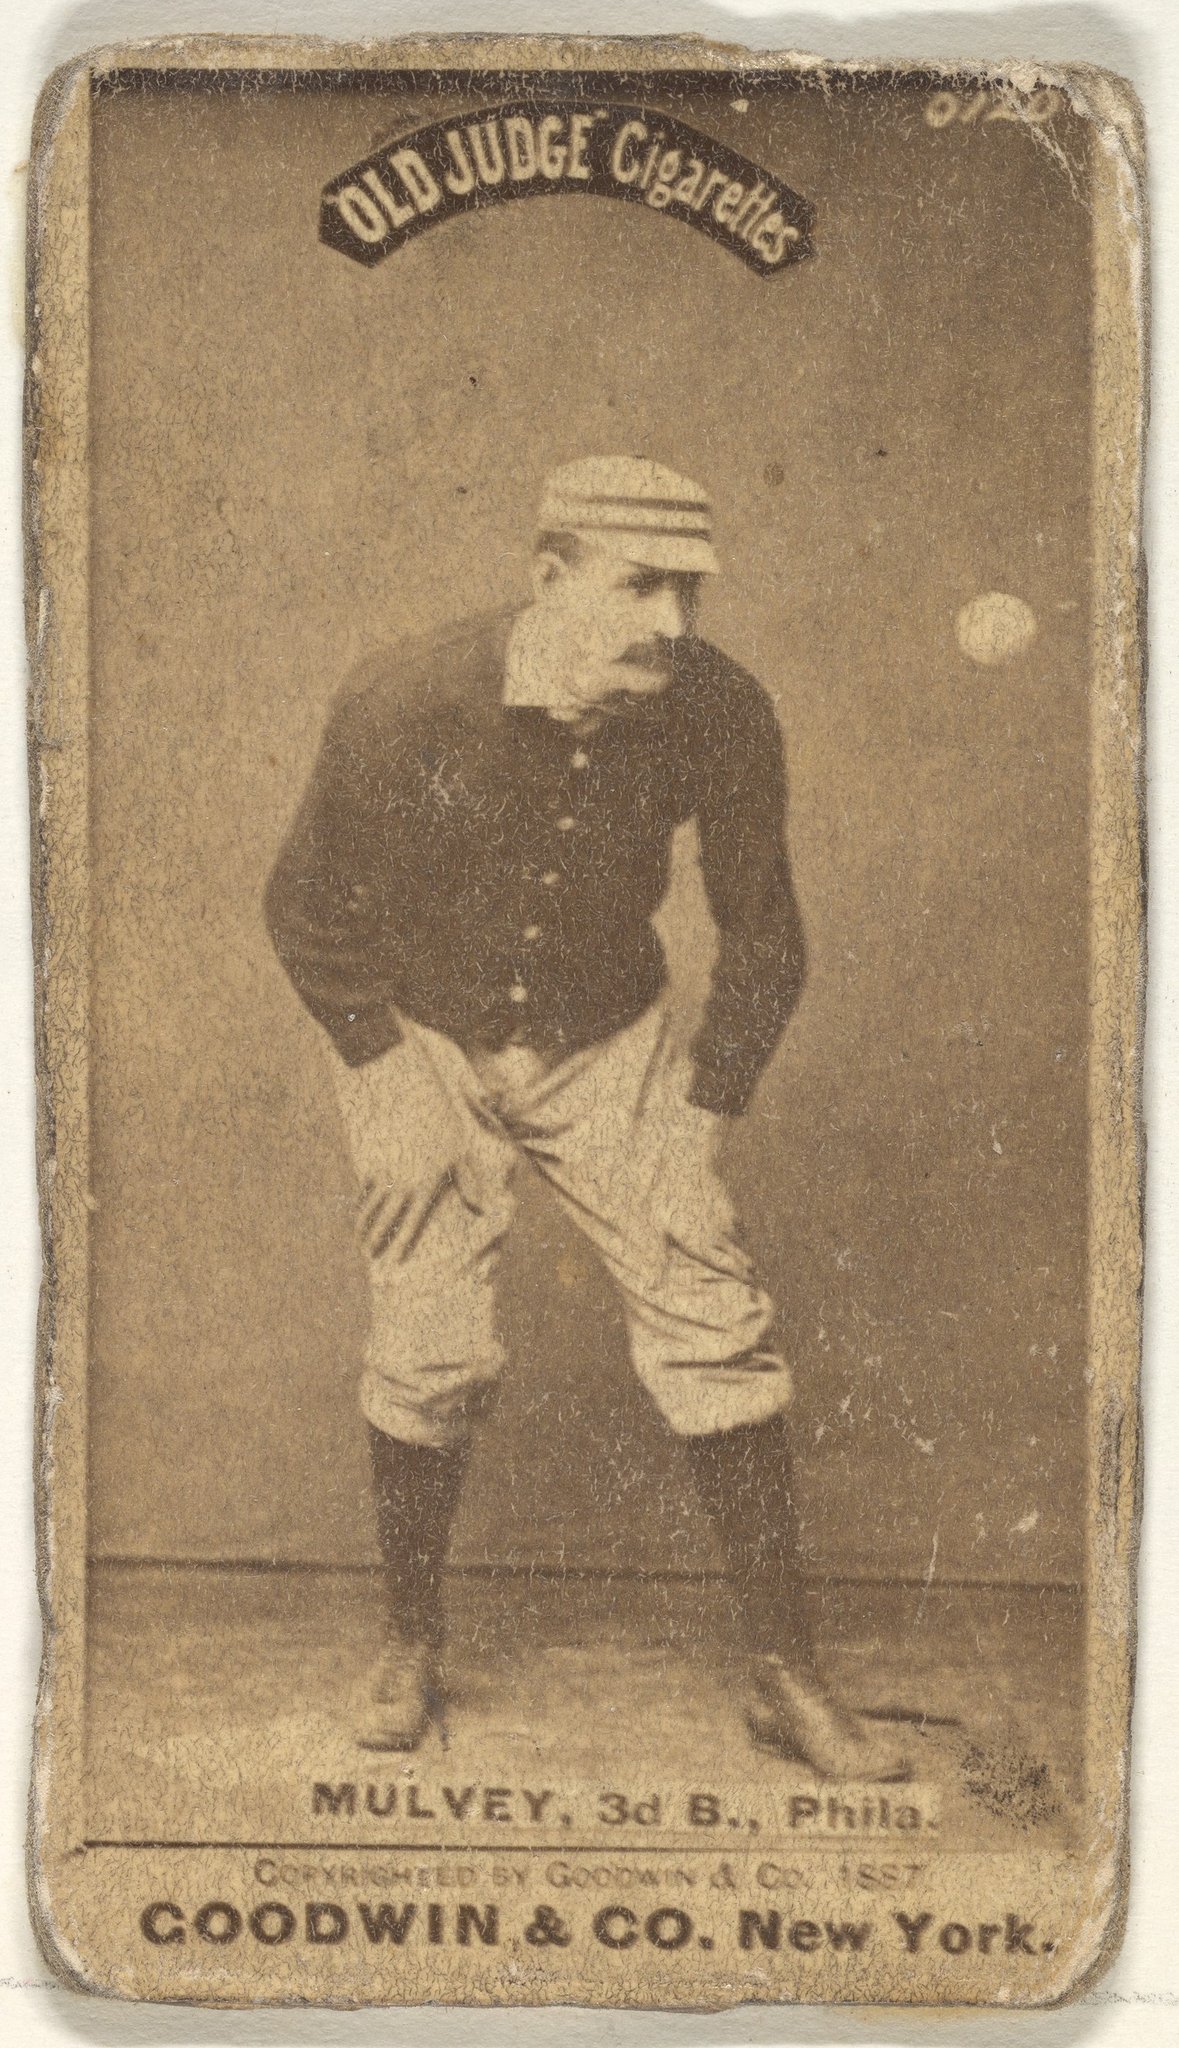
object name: baseball card, photograph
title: Joseph H. "Joe" Mulvey, 3rd Base, Philadelphia, from the Old Judge series (N172) for Old Judge Cigarettes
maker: goodwin & company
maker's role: publisher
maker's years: 1850-1950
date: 1887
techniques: albumen silver print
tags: men,portraits,baseball,athletes